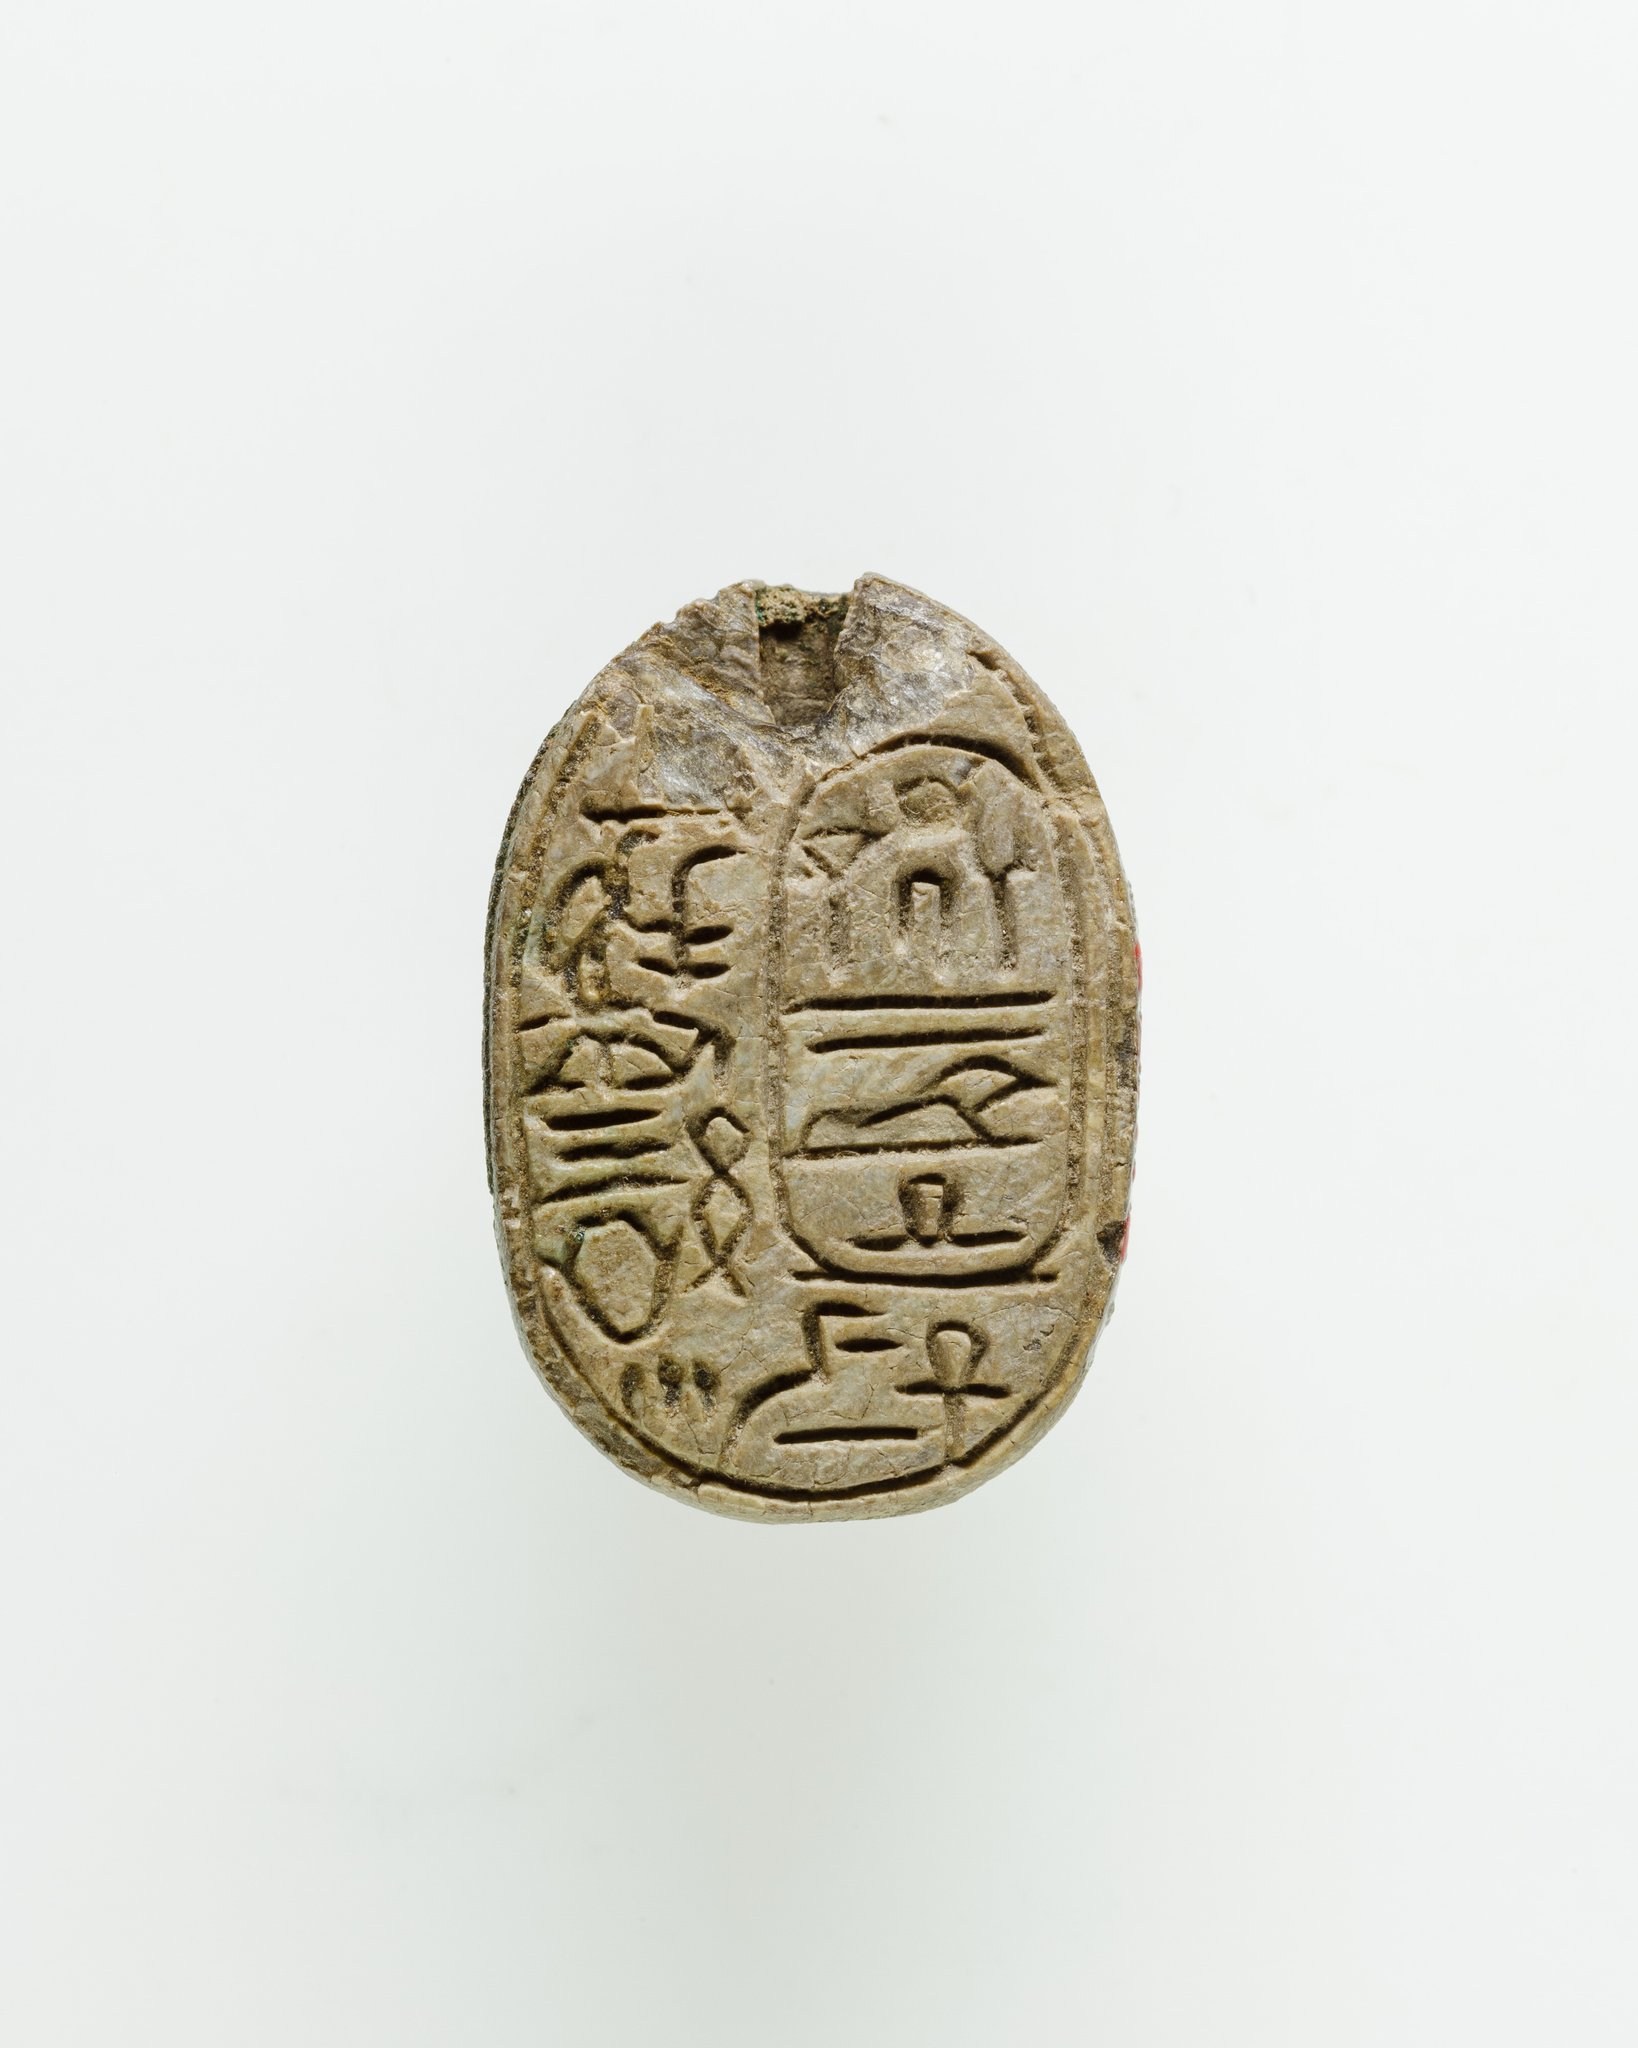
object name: scarab, sebekhotep iii, hieroglyph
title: Scarab of Sebekhotep III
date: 1748-1741 BCE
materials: glaze, stone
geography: egypt